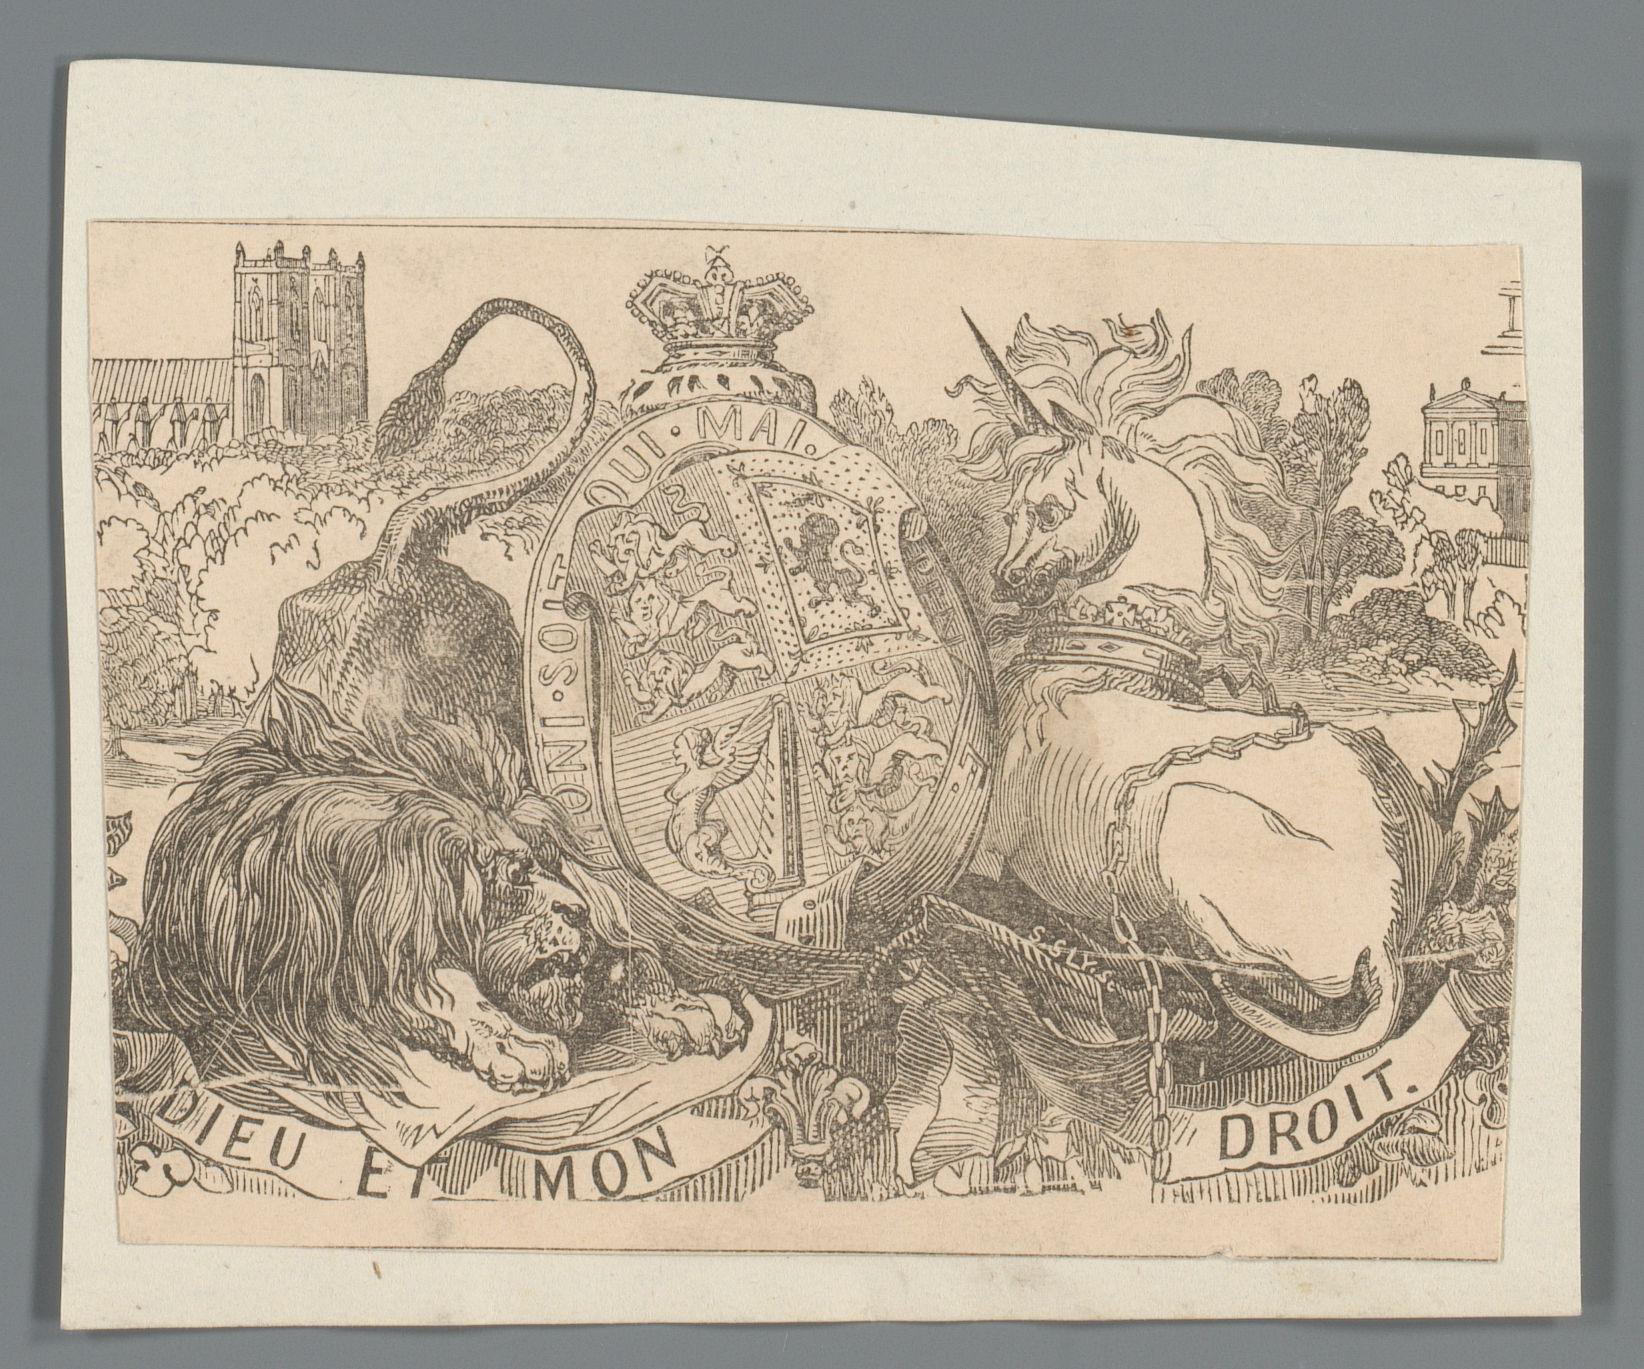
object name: print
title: Wapen van het Verenigd Koninkrijk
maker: stephen sly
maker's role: print maker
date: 1836-1847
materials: paper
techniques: engraving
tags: unicorn, city-view in general; 'veduta', beasts of prey, predatory animals: lion (+ heraldic animals), armorial bearing, heraldry, united kingdom